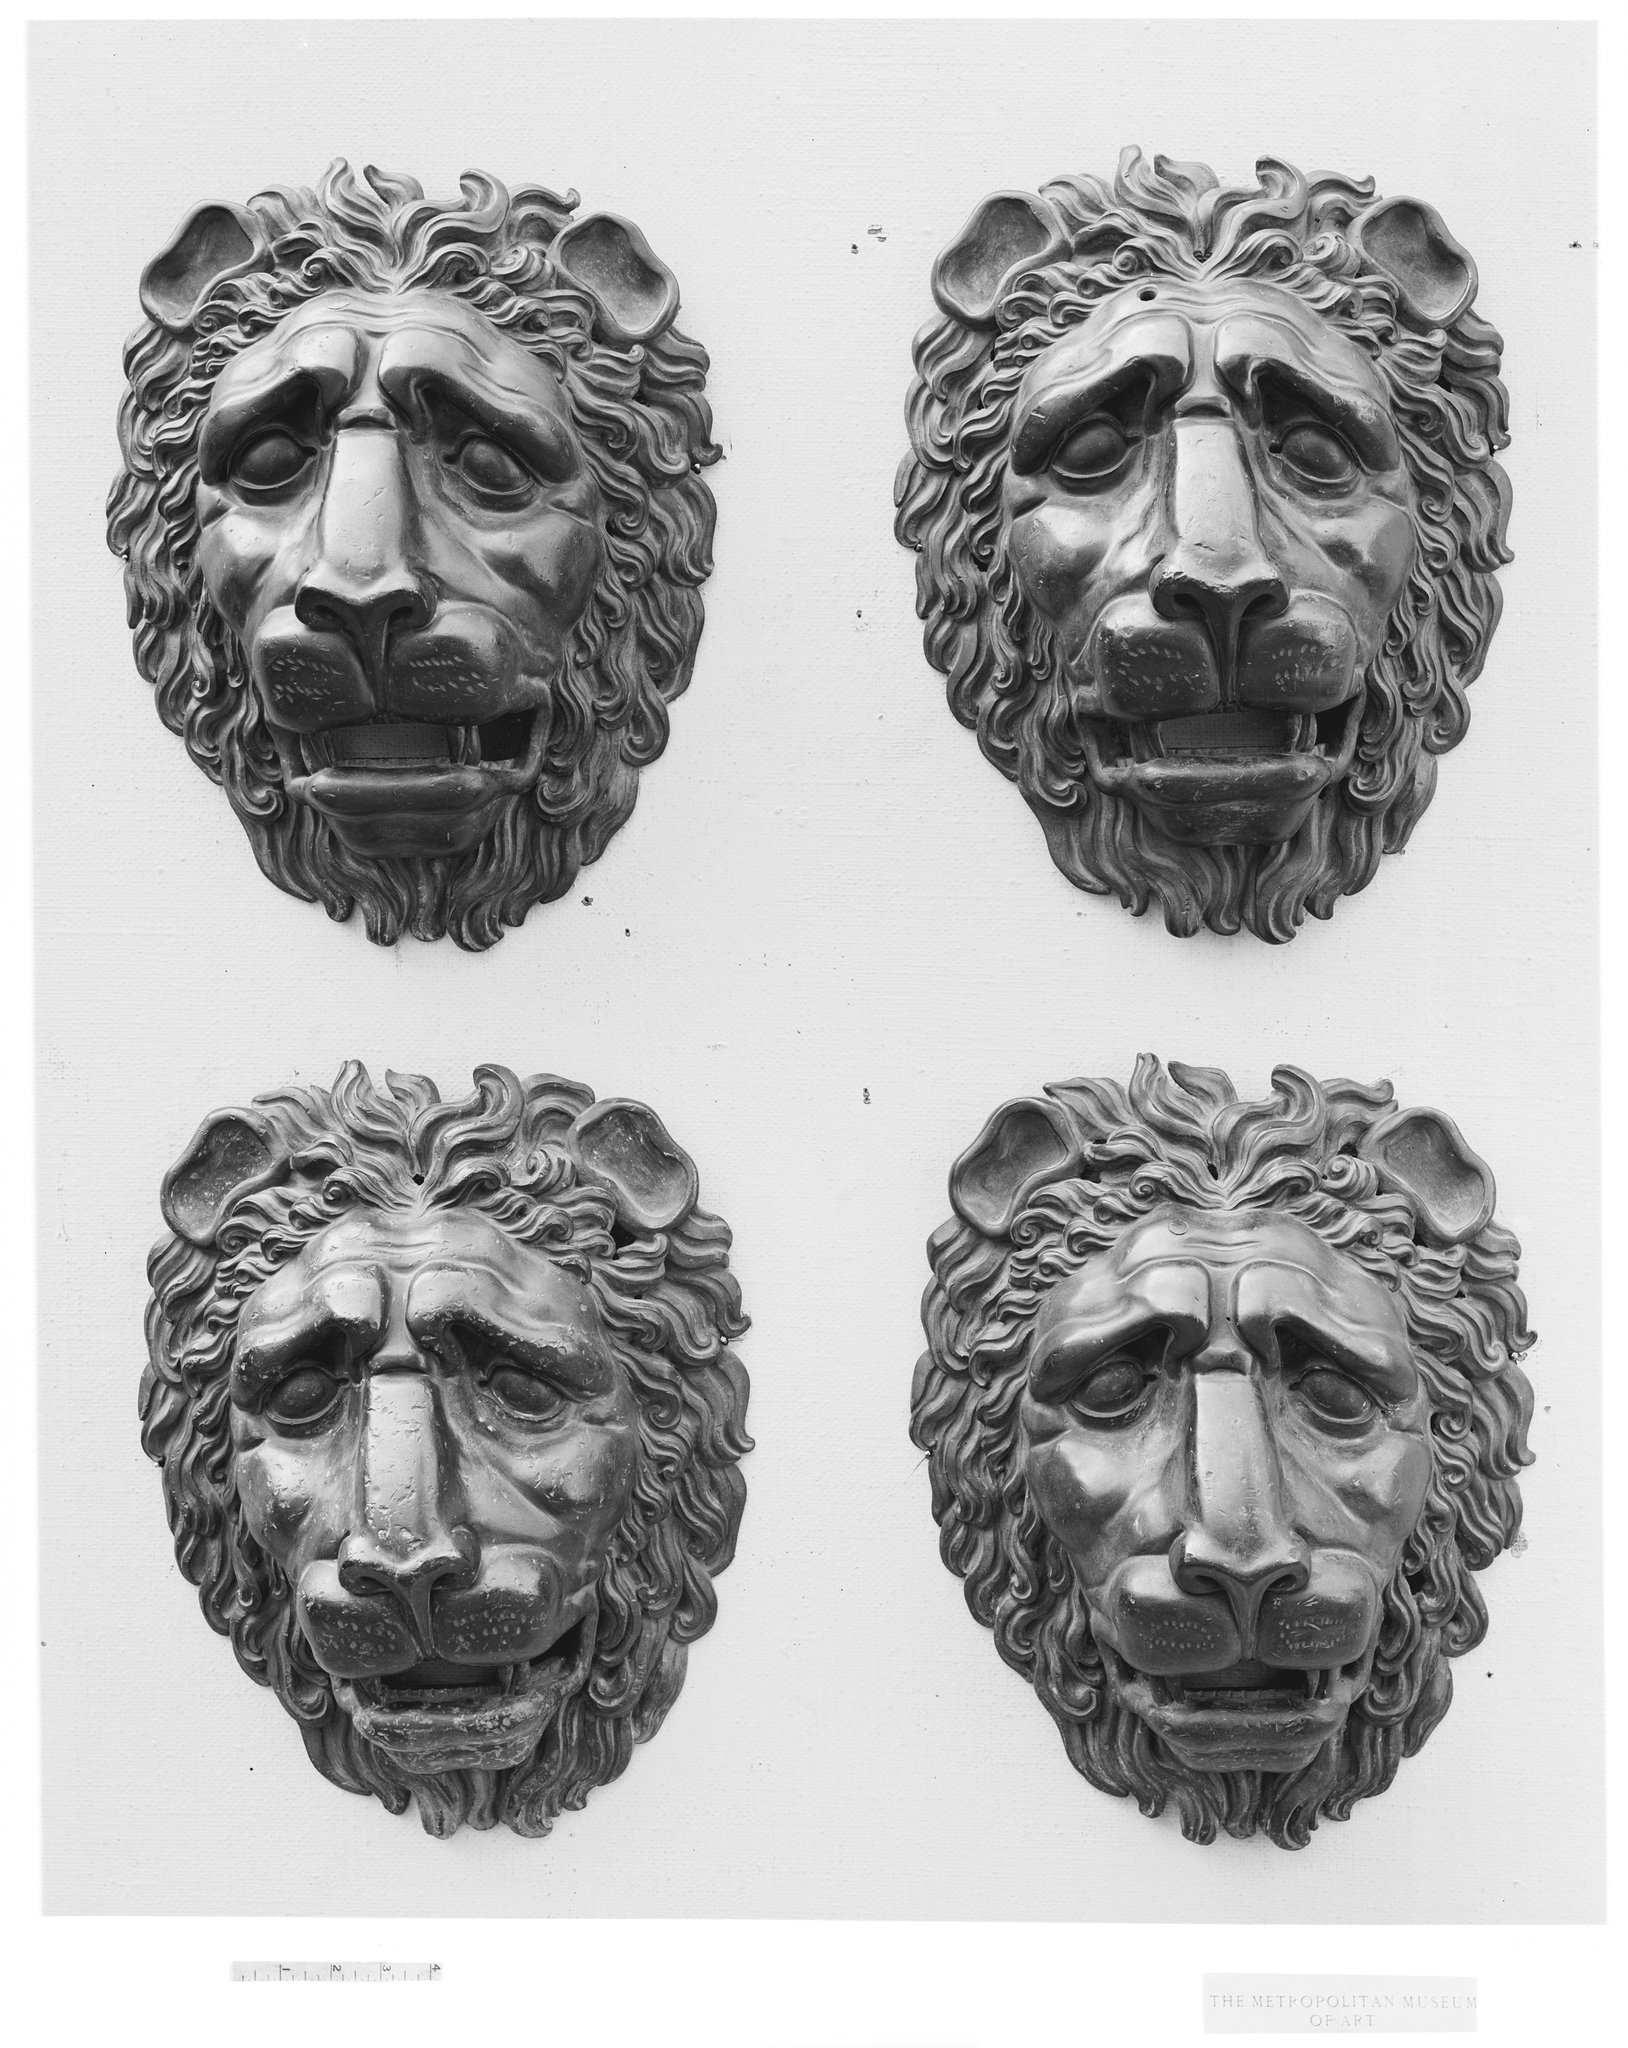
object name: figure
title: Set of four lion masks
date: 1601-1700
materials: bronze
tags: lions